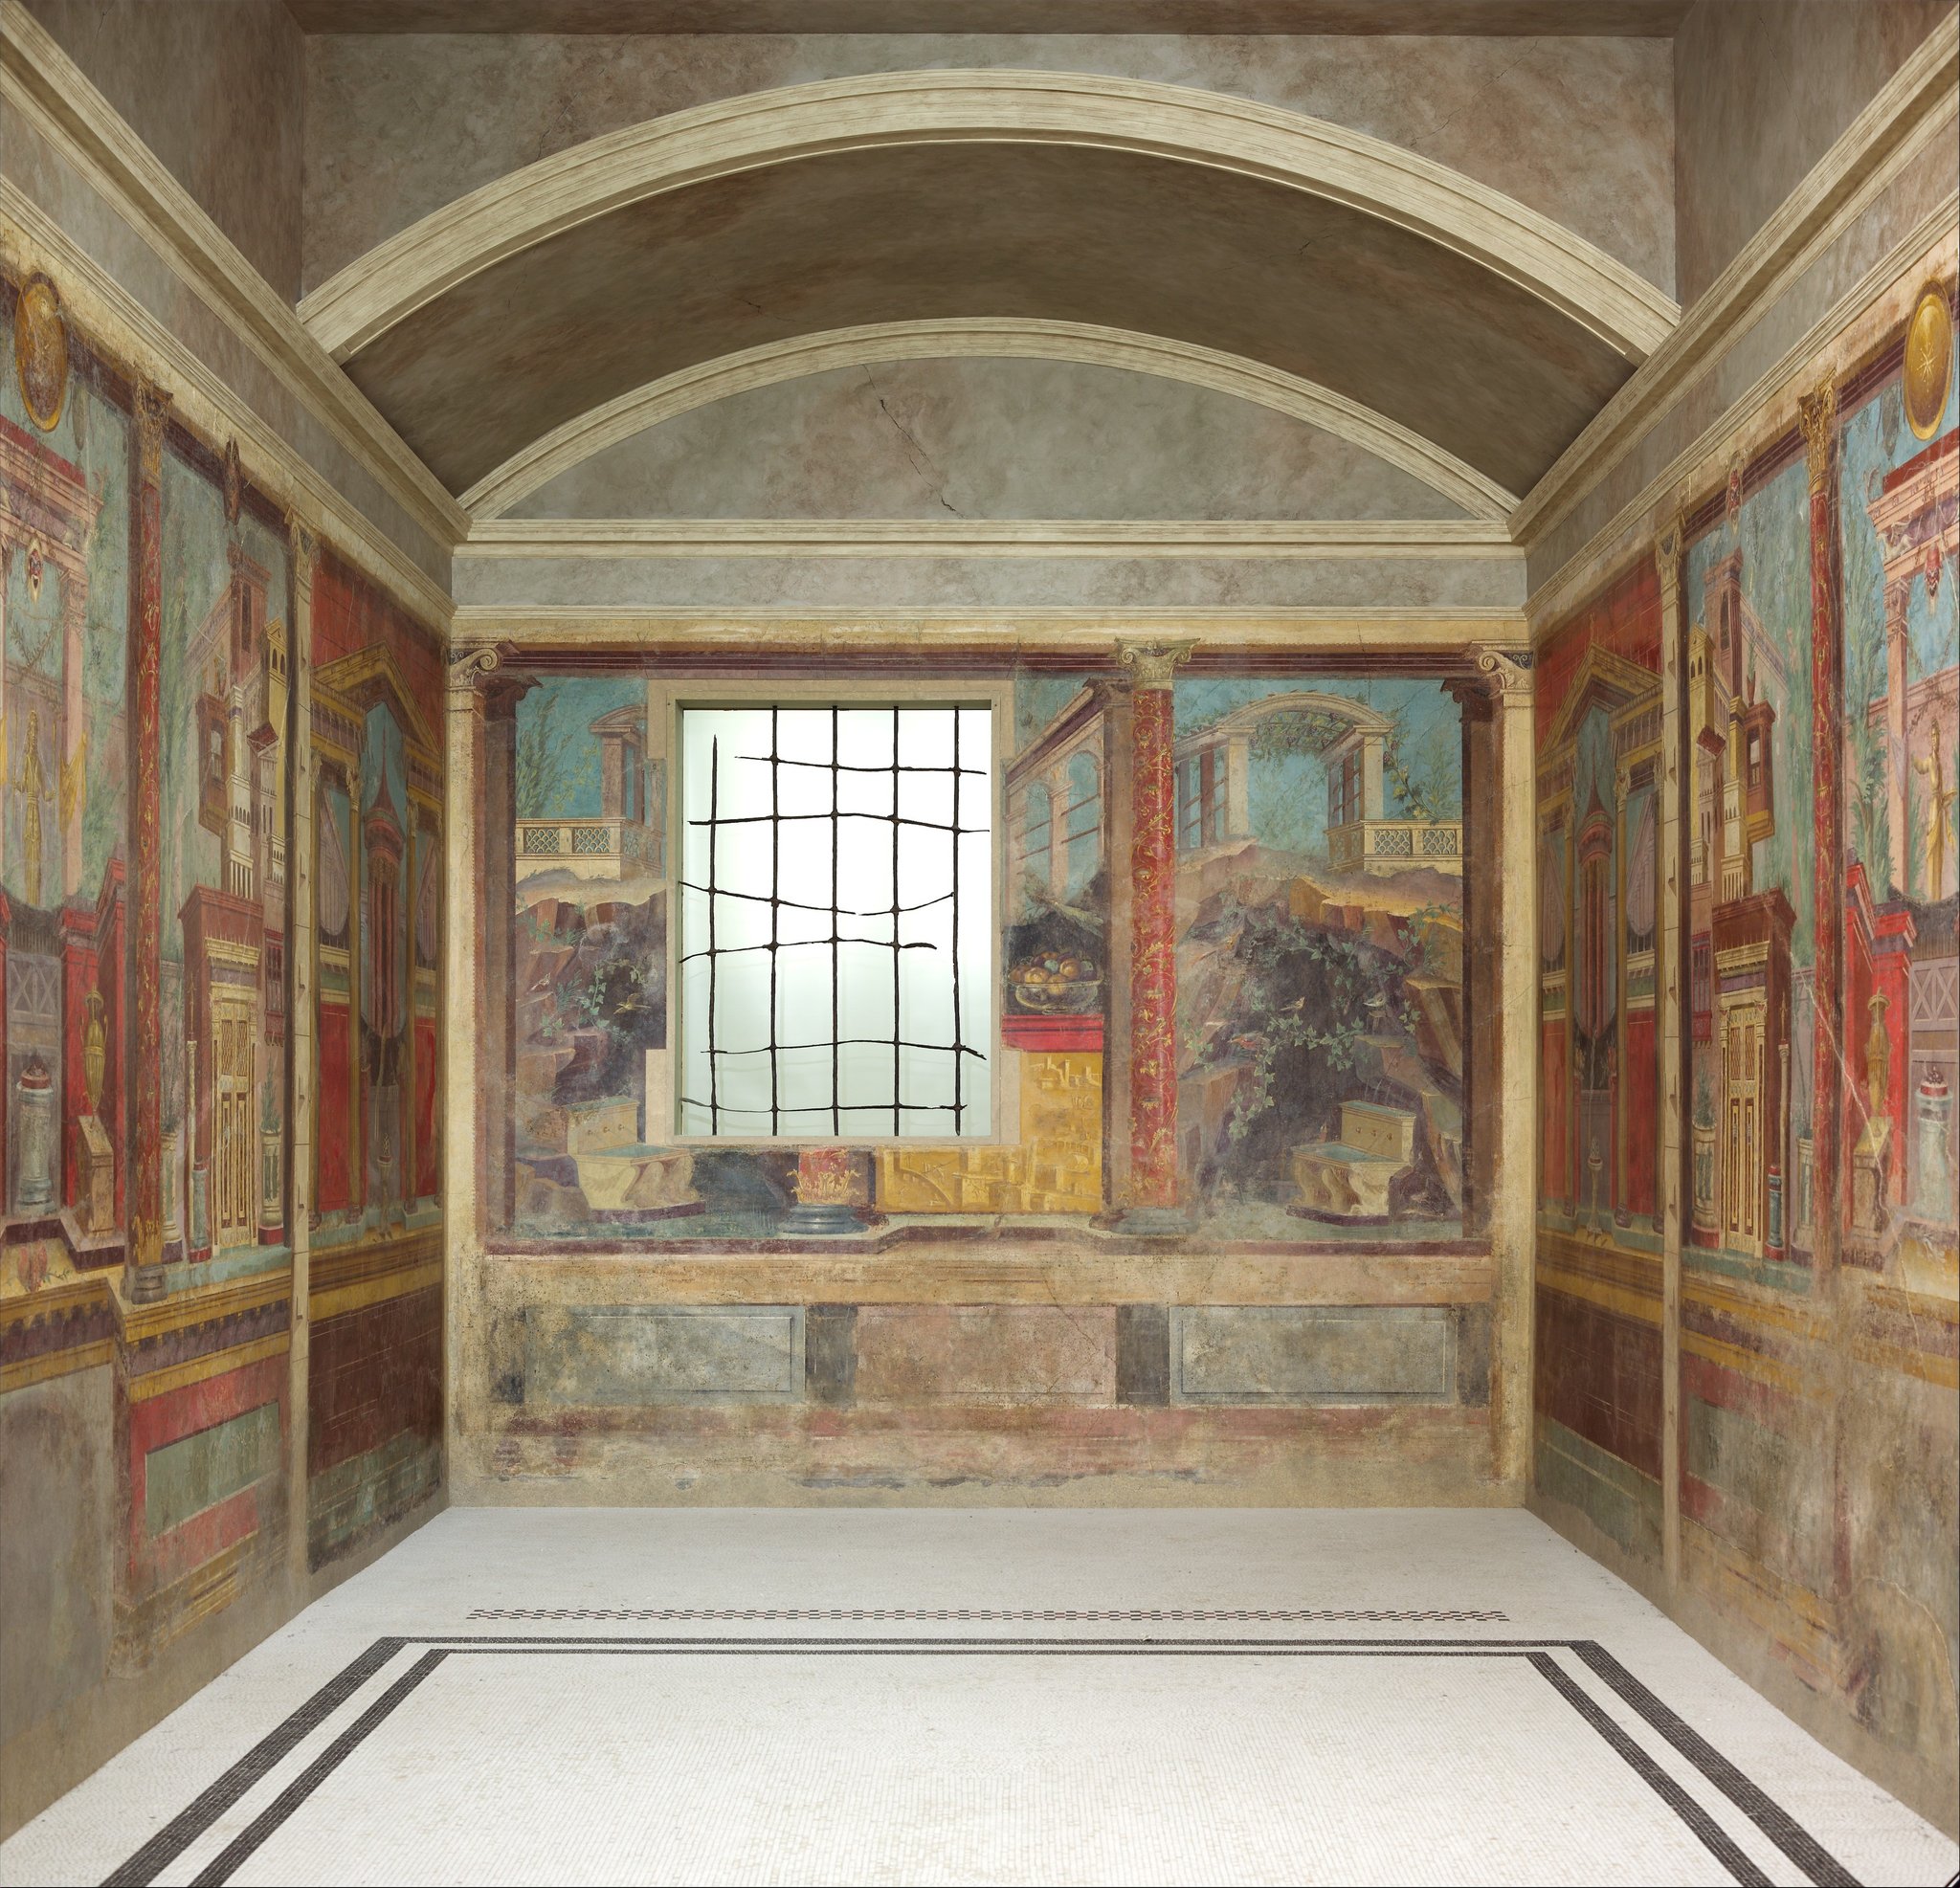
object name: cubiculum bedroom from the villa of p. fannius synistor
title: Cubiculum (bedroom) from the Villa of P. Fannius Synistor at Boscoreale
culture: roman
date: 50-40 BCE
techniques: fresco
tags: interiors,bedrooms